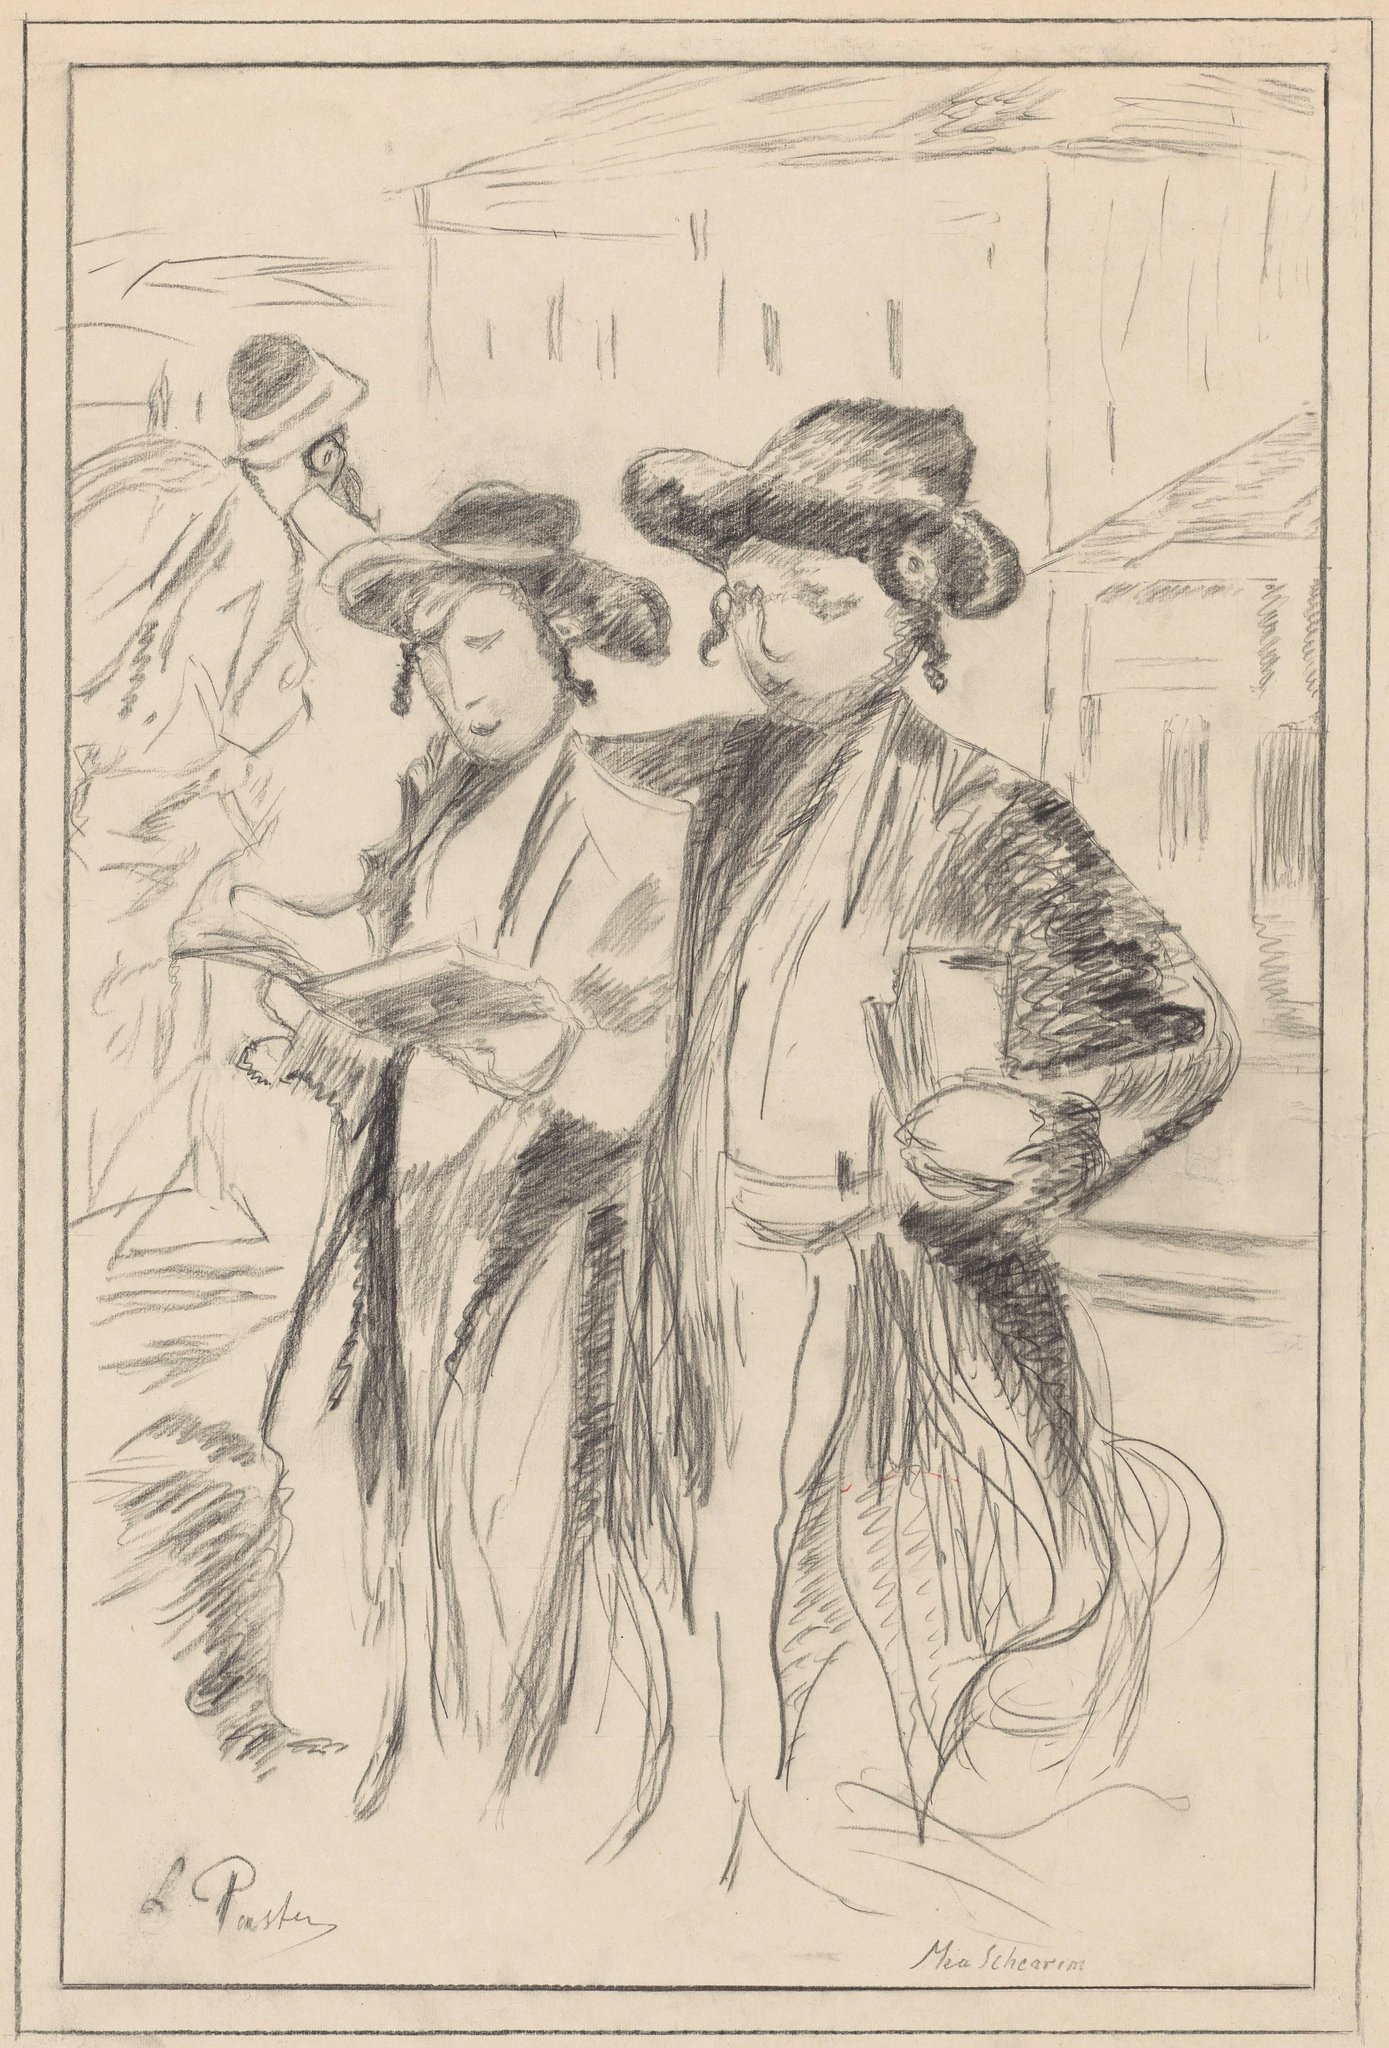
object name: print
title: Mea Schearim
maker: Anonymous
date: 1900-1999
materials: chalk, paper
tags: book, the jews, jewish life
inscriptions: collector's mark: Lugt 2228, collector's mark: Lugt 4780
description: Twee jongens met hoeden, lange jassen en peies. Ze dragen boeken onder hun arm.